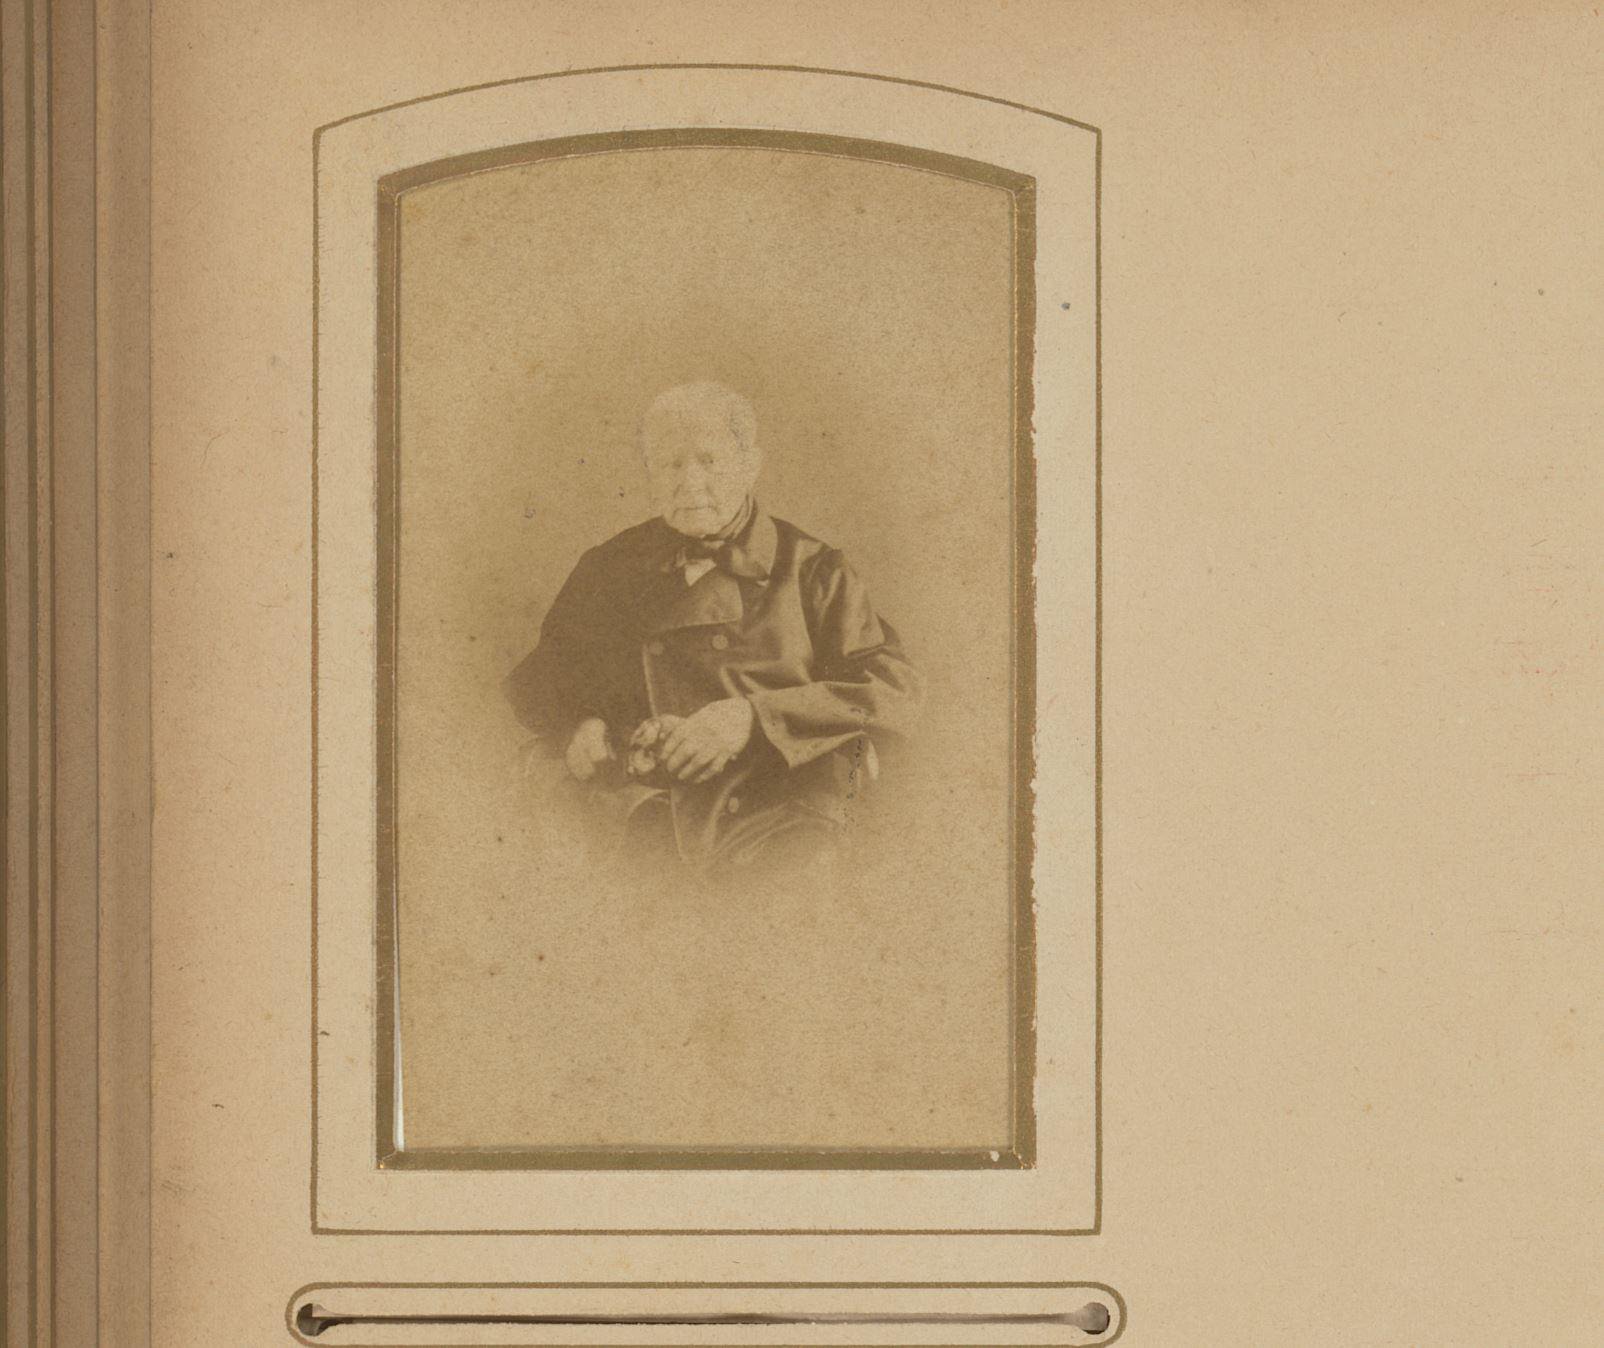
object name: photograph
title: Portret van een oude man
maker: Anonymous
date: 1850-1880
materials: cardboard, photographic support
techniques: albumen print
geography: belgium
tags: historical persons, old man